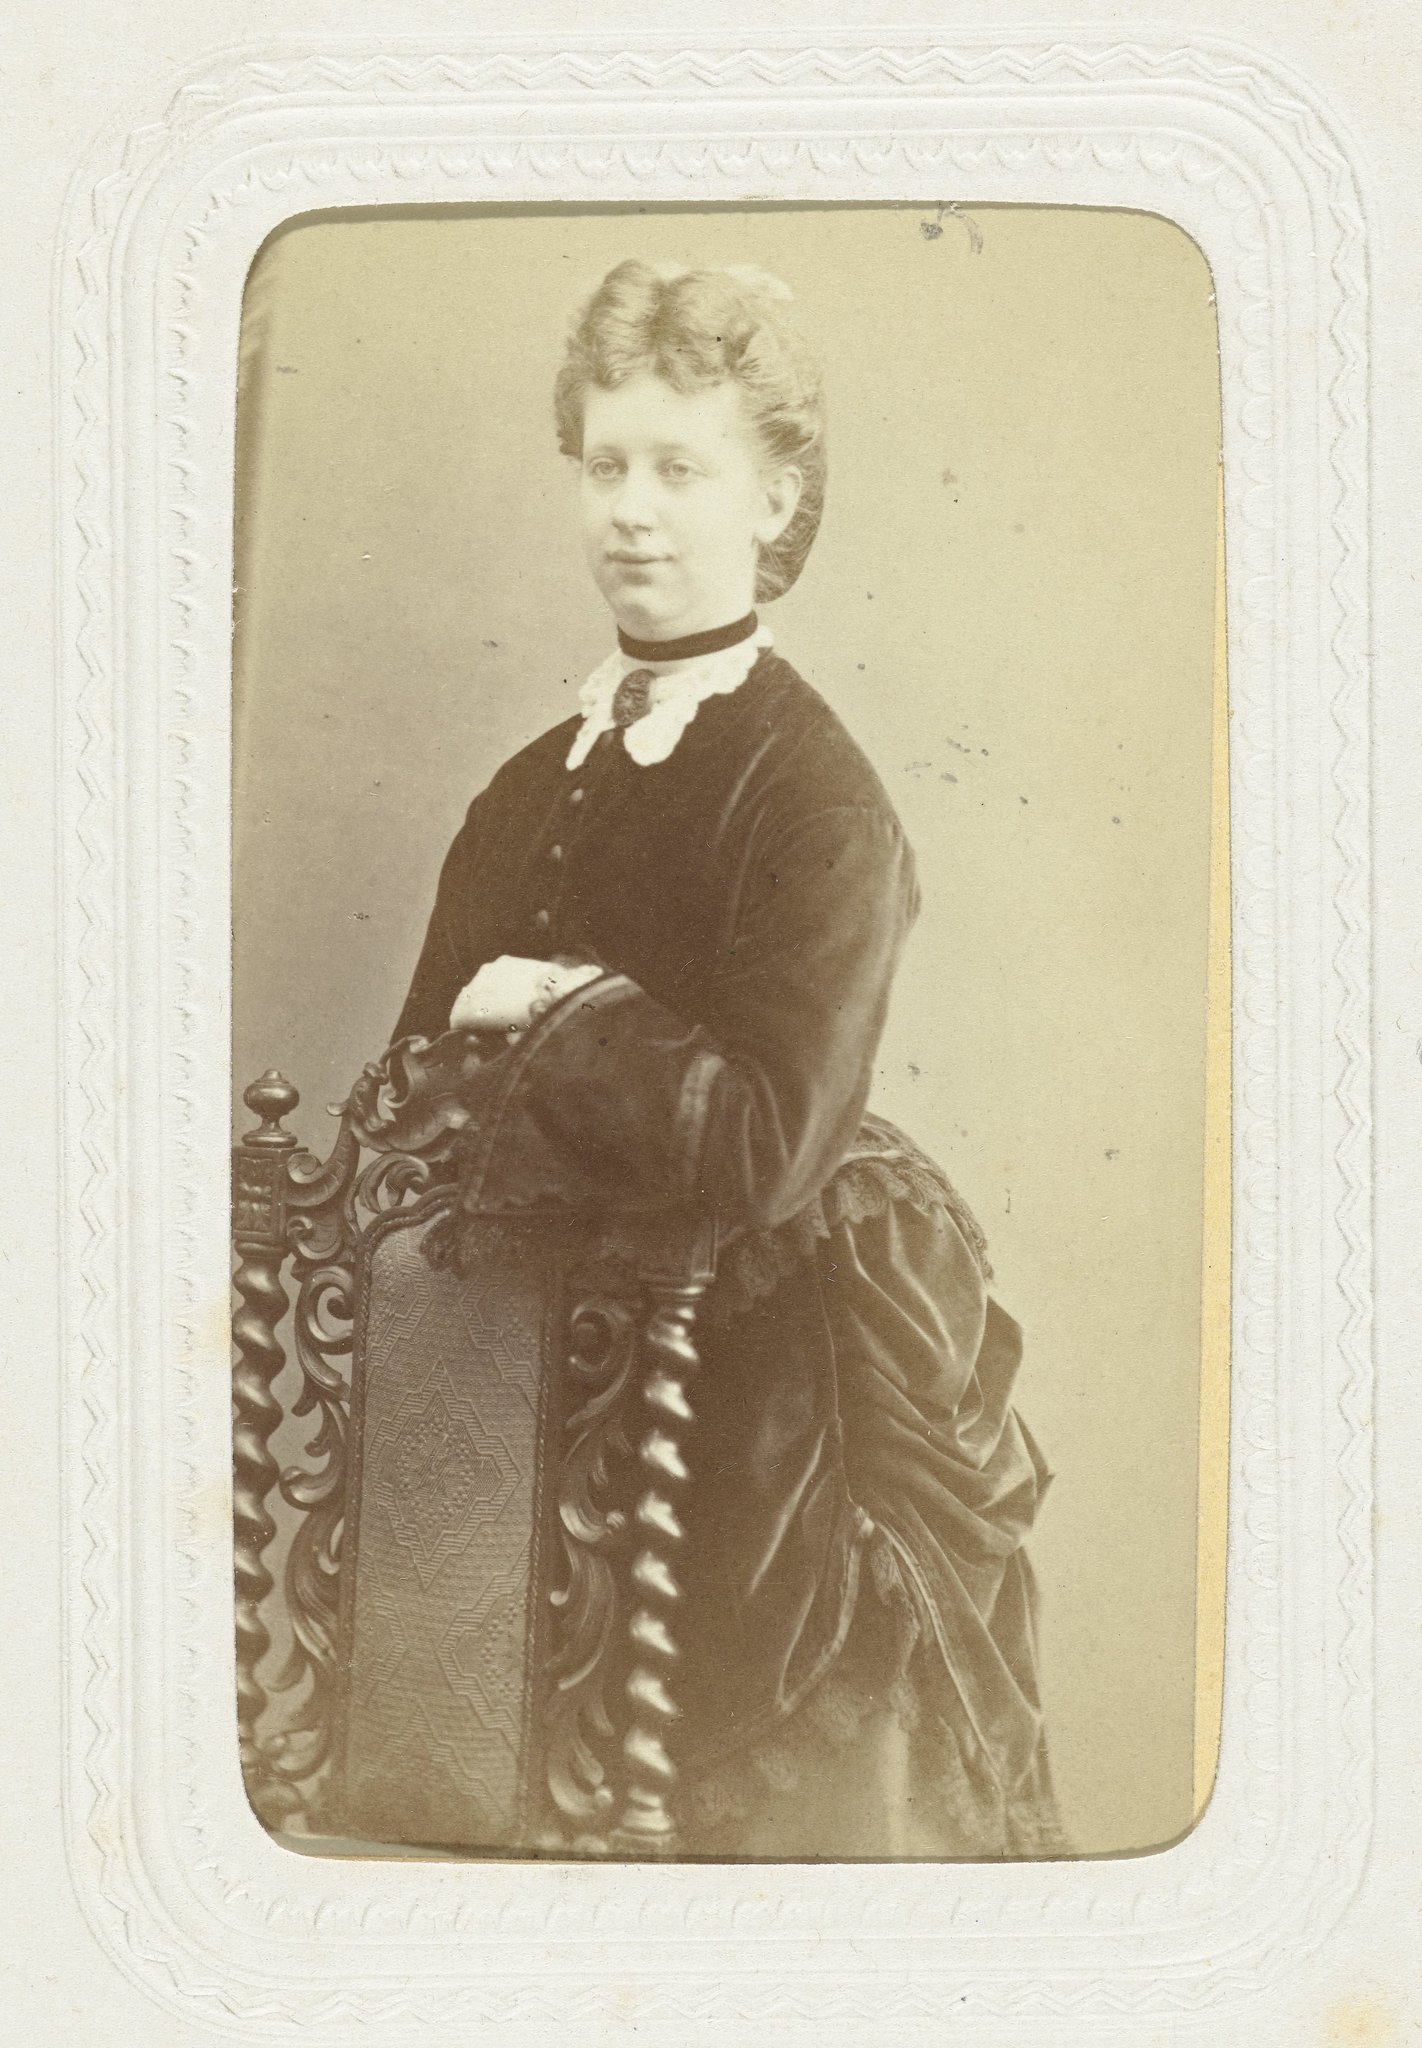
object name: carte de visite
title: Studioportret van een blonde vrouw in een lange zwarte jurk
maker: albert greiner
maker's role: fotograaf, fotostudio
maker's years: 1833-1890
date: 1863-1866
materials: cardboard, paper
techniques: albumen print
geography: amsterdam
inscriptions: date: ‘16 april '72’, name: ‘Greiner, Albert, Amsterdam’